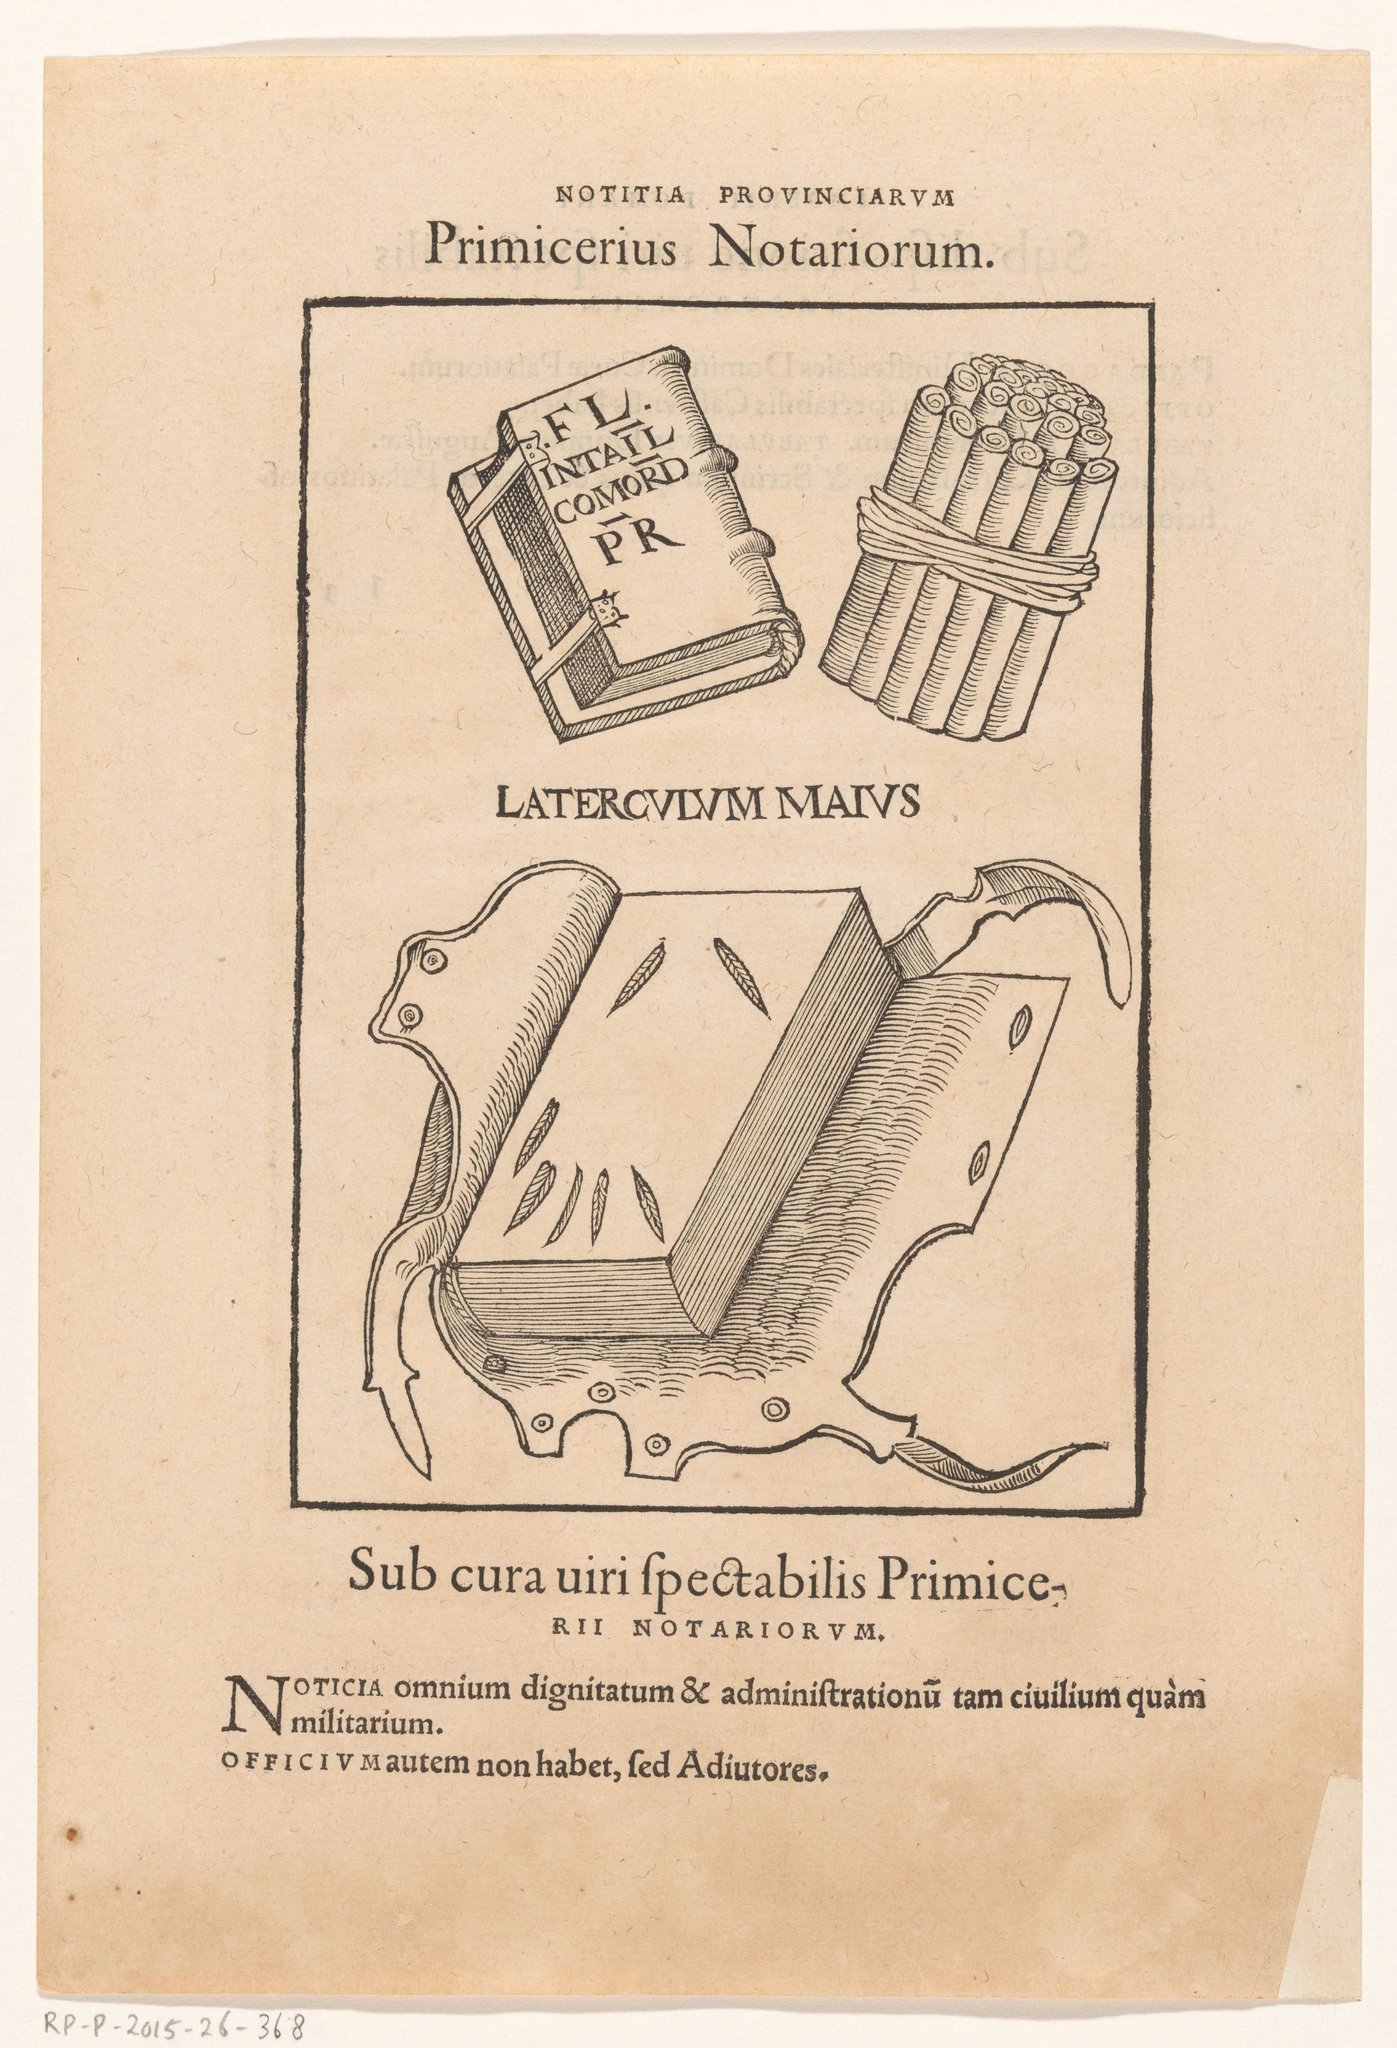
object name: print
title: Twee boeken en een roedenbundel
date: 1552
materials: paper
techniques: letterpress printing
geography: basel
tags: book, insignia and symbols of sovereignty (crown, diadem, sceptre, orb, seal, standard, cloak, pectoral)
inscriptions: collector's mark: Lugt 2228, collector's mark: Lugt 4780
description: Prent waarschijnlijk afkomstig uit: Notitia utraque cum orientis tum occidentis. Basel: Nicolaus Episcopus en Hieronymus Froben, 1552. Dit was de eerste geïllustreerde edite van Notitia dignitatum, een overzicht van het bestuur van het Romeinse Rijk uit ca. 400.